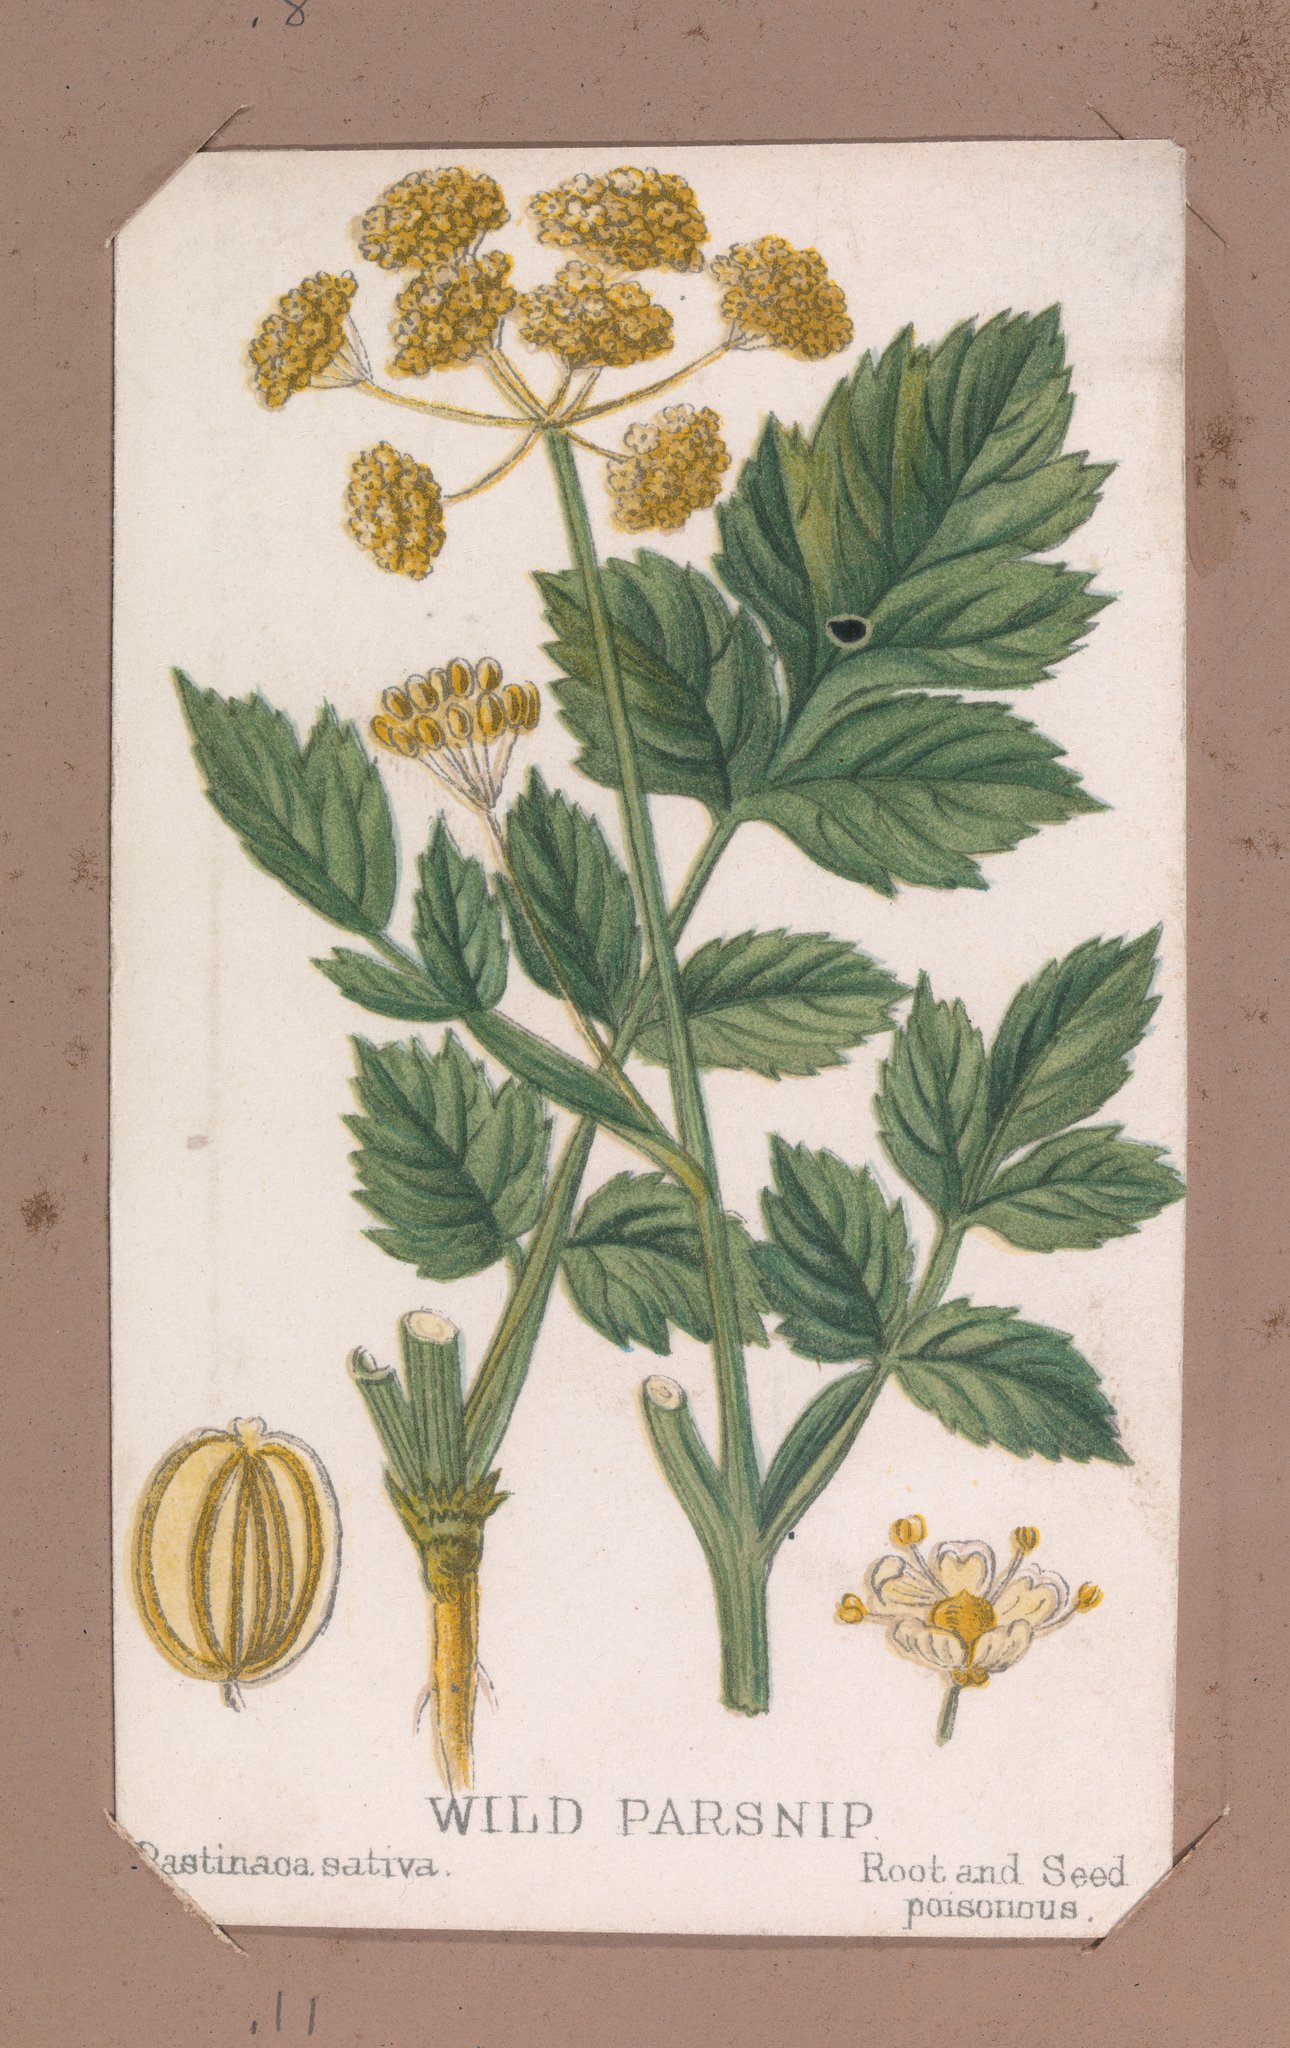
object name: album card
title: Wild Parsnip from the Plants series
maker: louis prang & co.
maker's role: publisher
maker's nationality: american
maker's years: 1800-1950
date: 1862-1869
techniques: lithograph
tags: plants